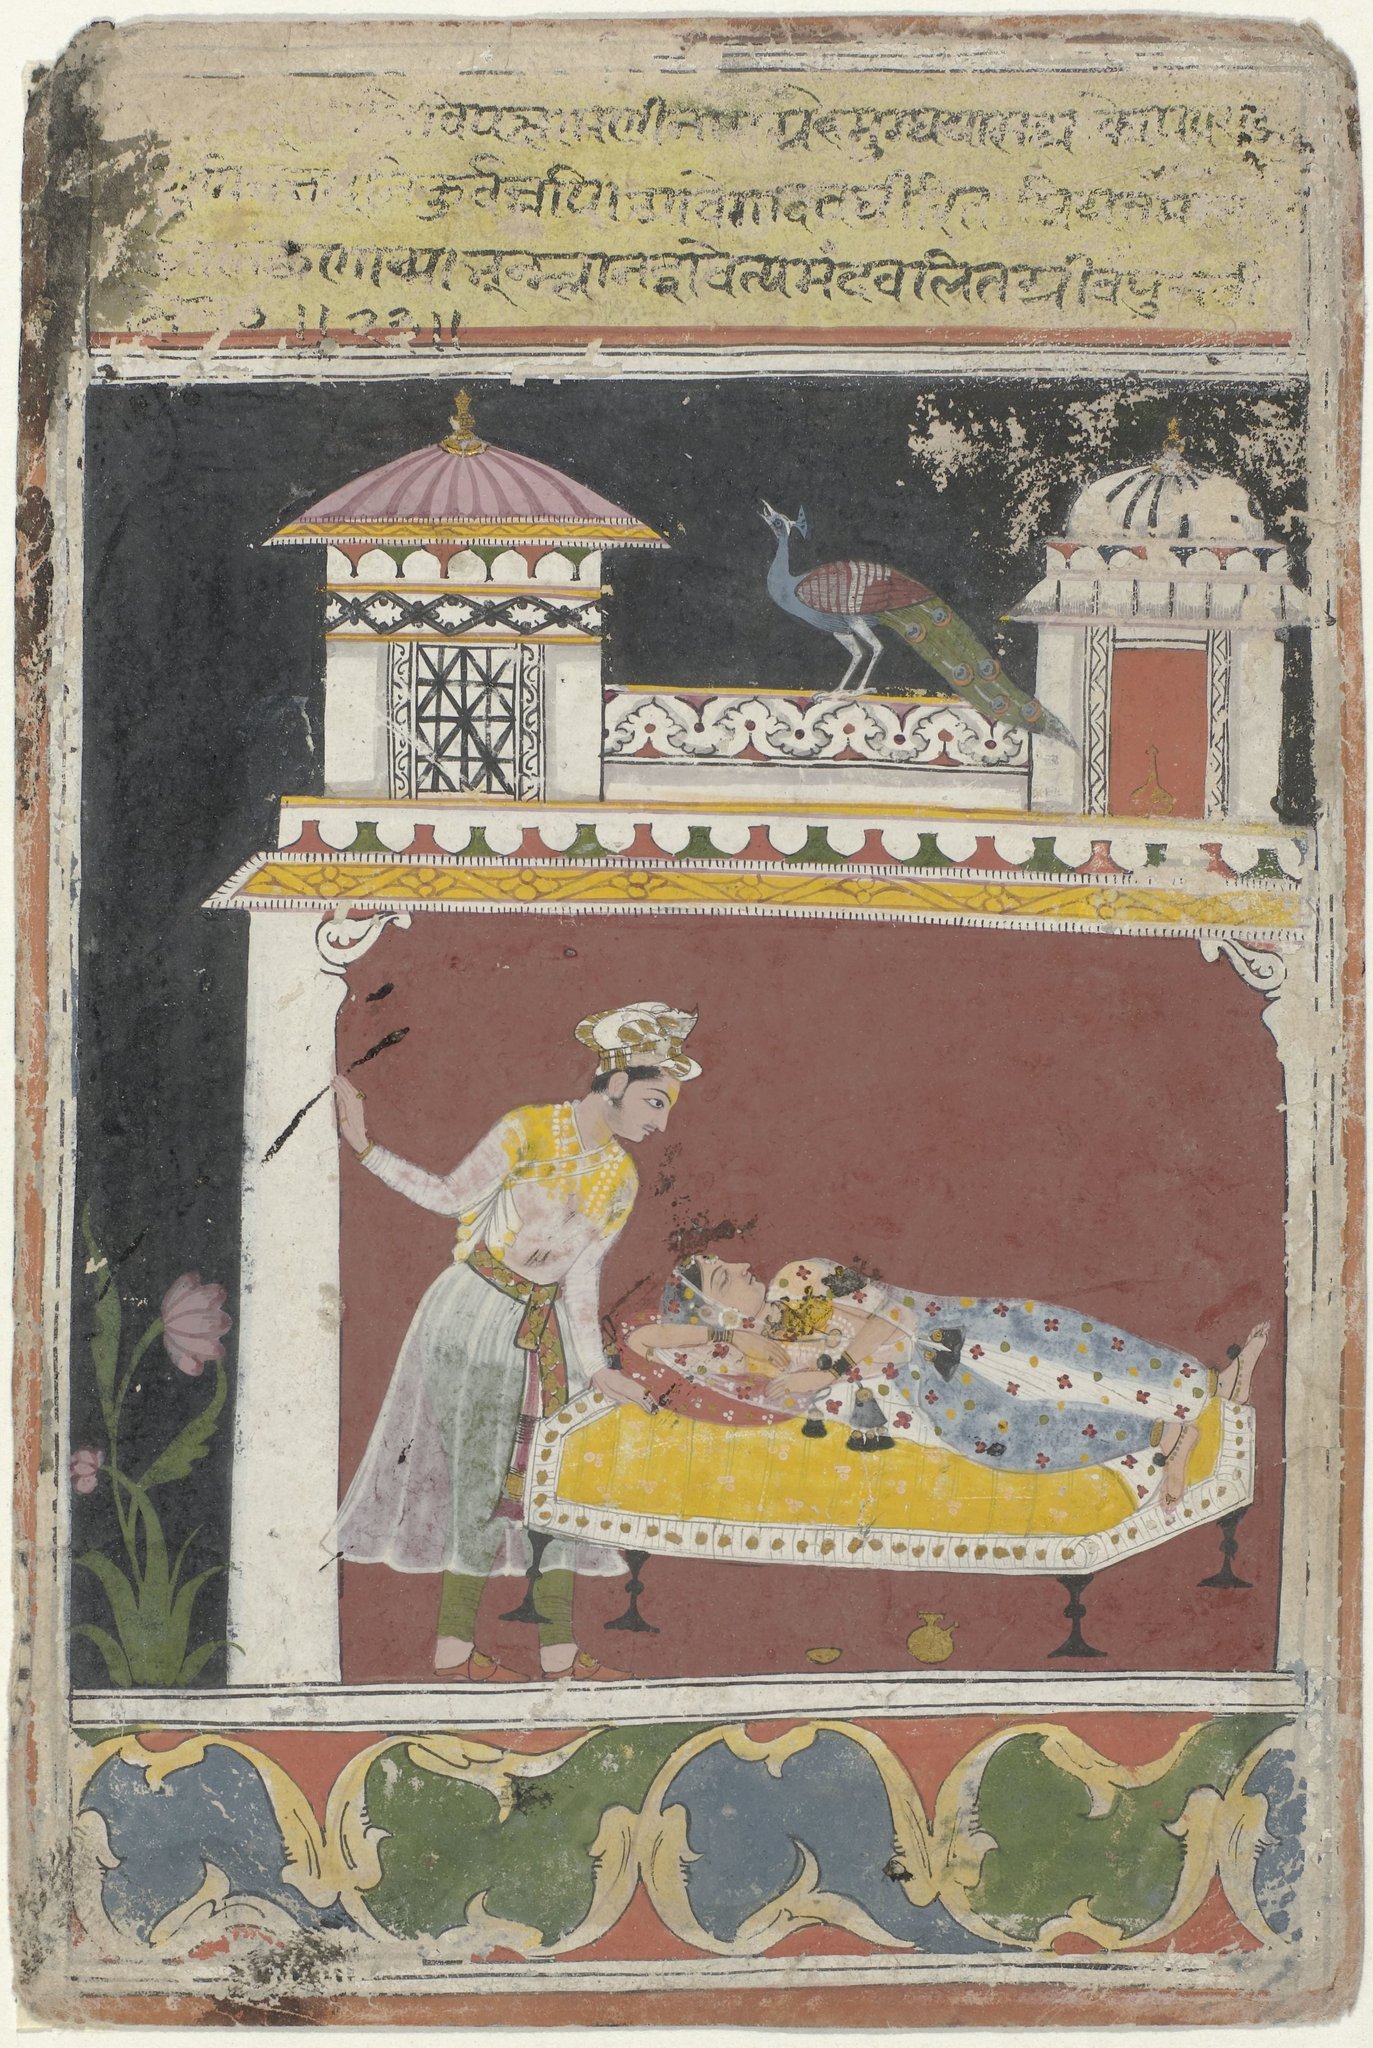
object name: indian miniature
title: Lakta ragini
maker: Anonymous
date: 1650-1670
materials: paper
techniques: brush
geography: central india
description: Een prins verlaat zijn slapende geliefde die op een geel bed ligt, op het dak van haar paleis staat een pauw. Onderaan de voorstelling een brede decoratieve rand van een slingerende gele rand rond blauwe en groene medaillons tegen een rode achtergrond; bovenaan een brede gele rand met een 3-regelige inscriptie in oud-Indisch schrift.